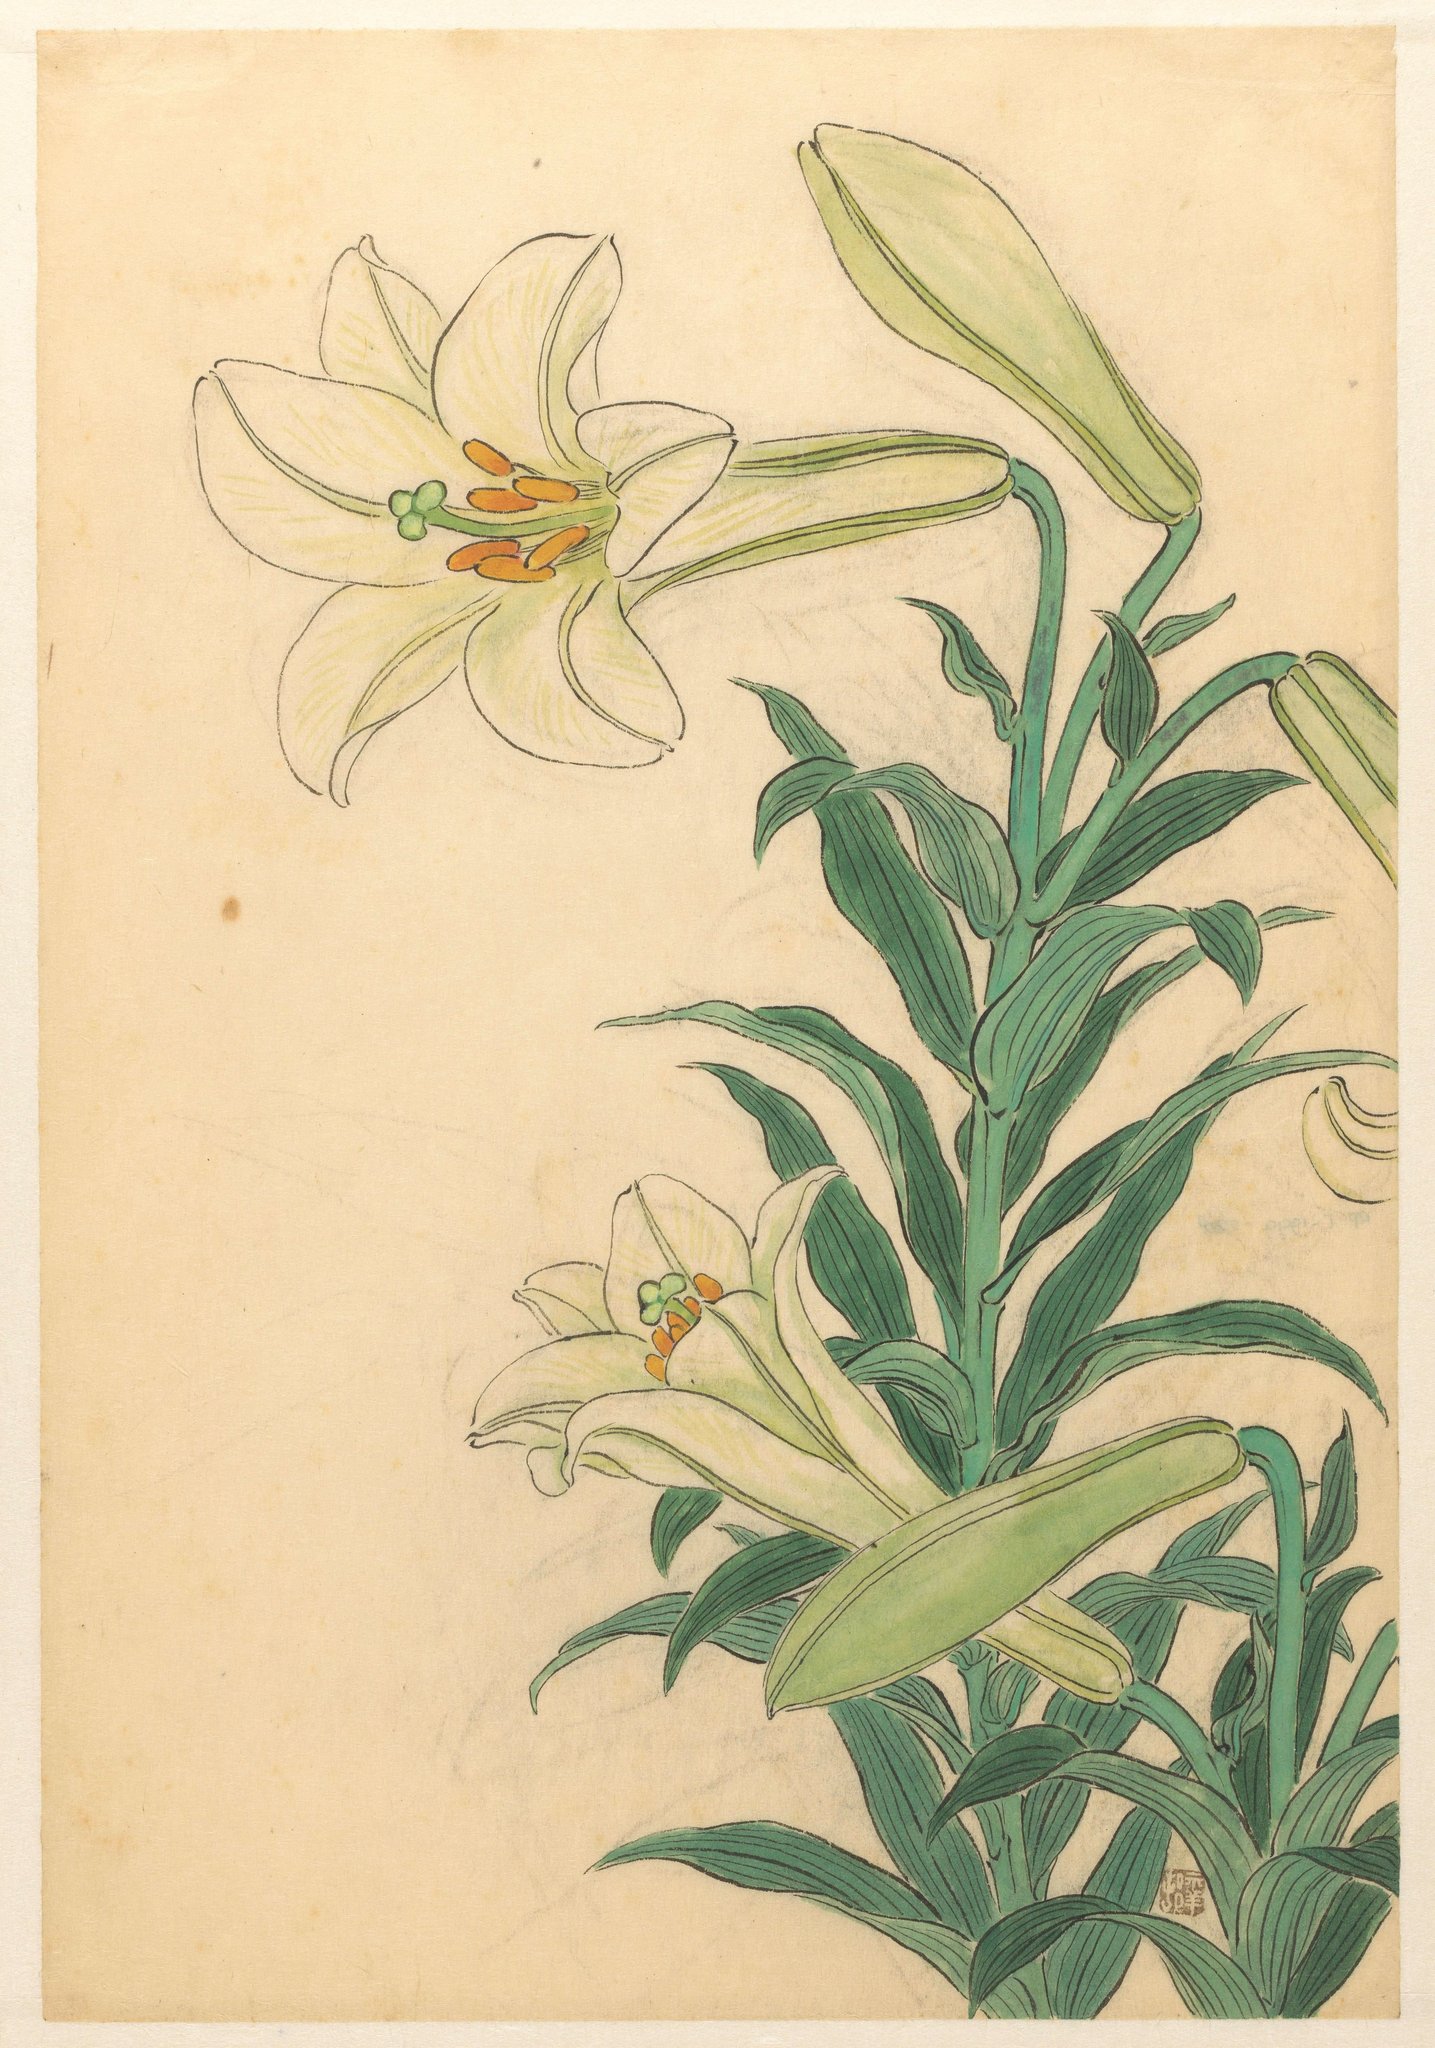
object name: drawing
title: Teppoyuri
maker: ohara koson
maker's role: print maker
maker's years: 1877-1945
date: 1912-1930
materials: paper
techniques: brush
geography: japan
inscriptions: collector's mark: Lugt 2228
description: Ontwerptekening voor een prent. Japanse titel vermeld op bijgevoegd label.